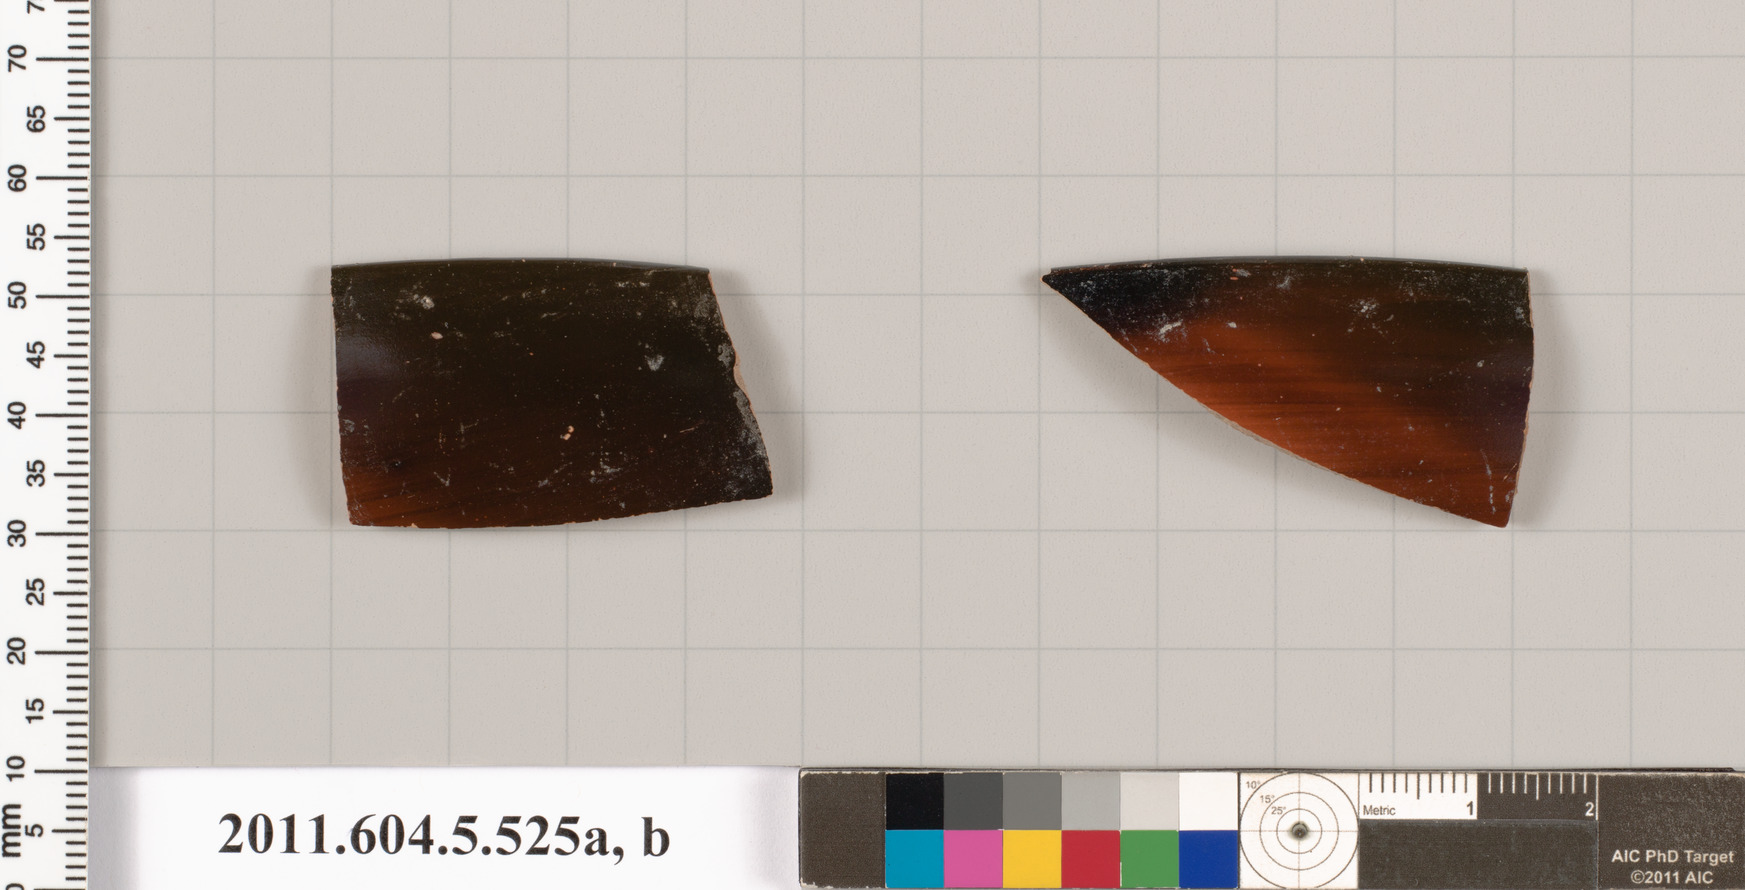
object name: kylix fragment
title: Terracotta rim fragments of a kylix (drinking cup)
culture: greek, attic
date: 600-401 BCE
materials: terracotta